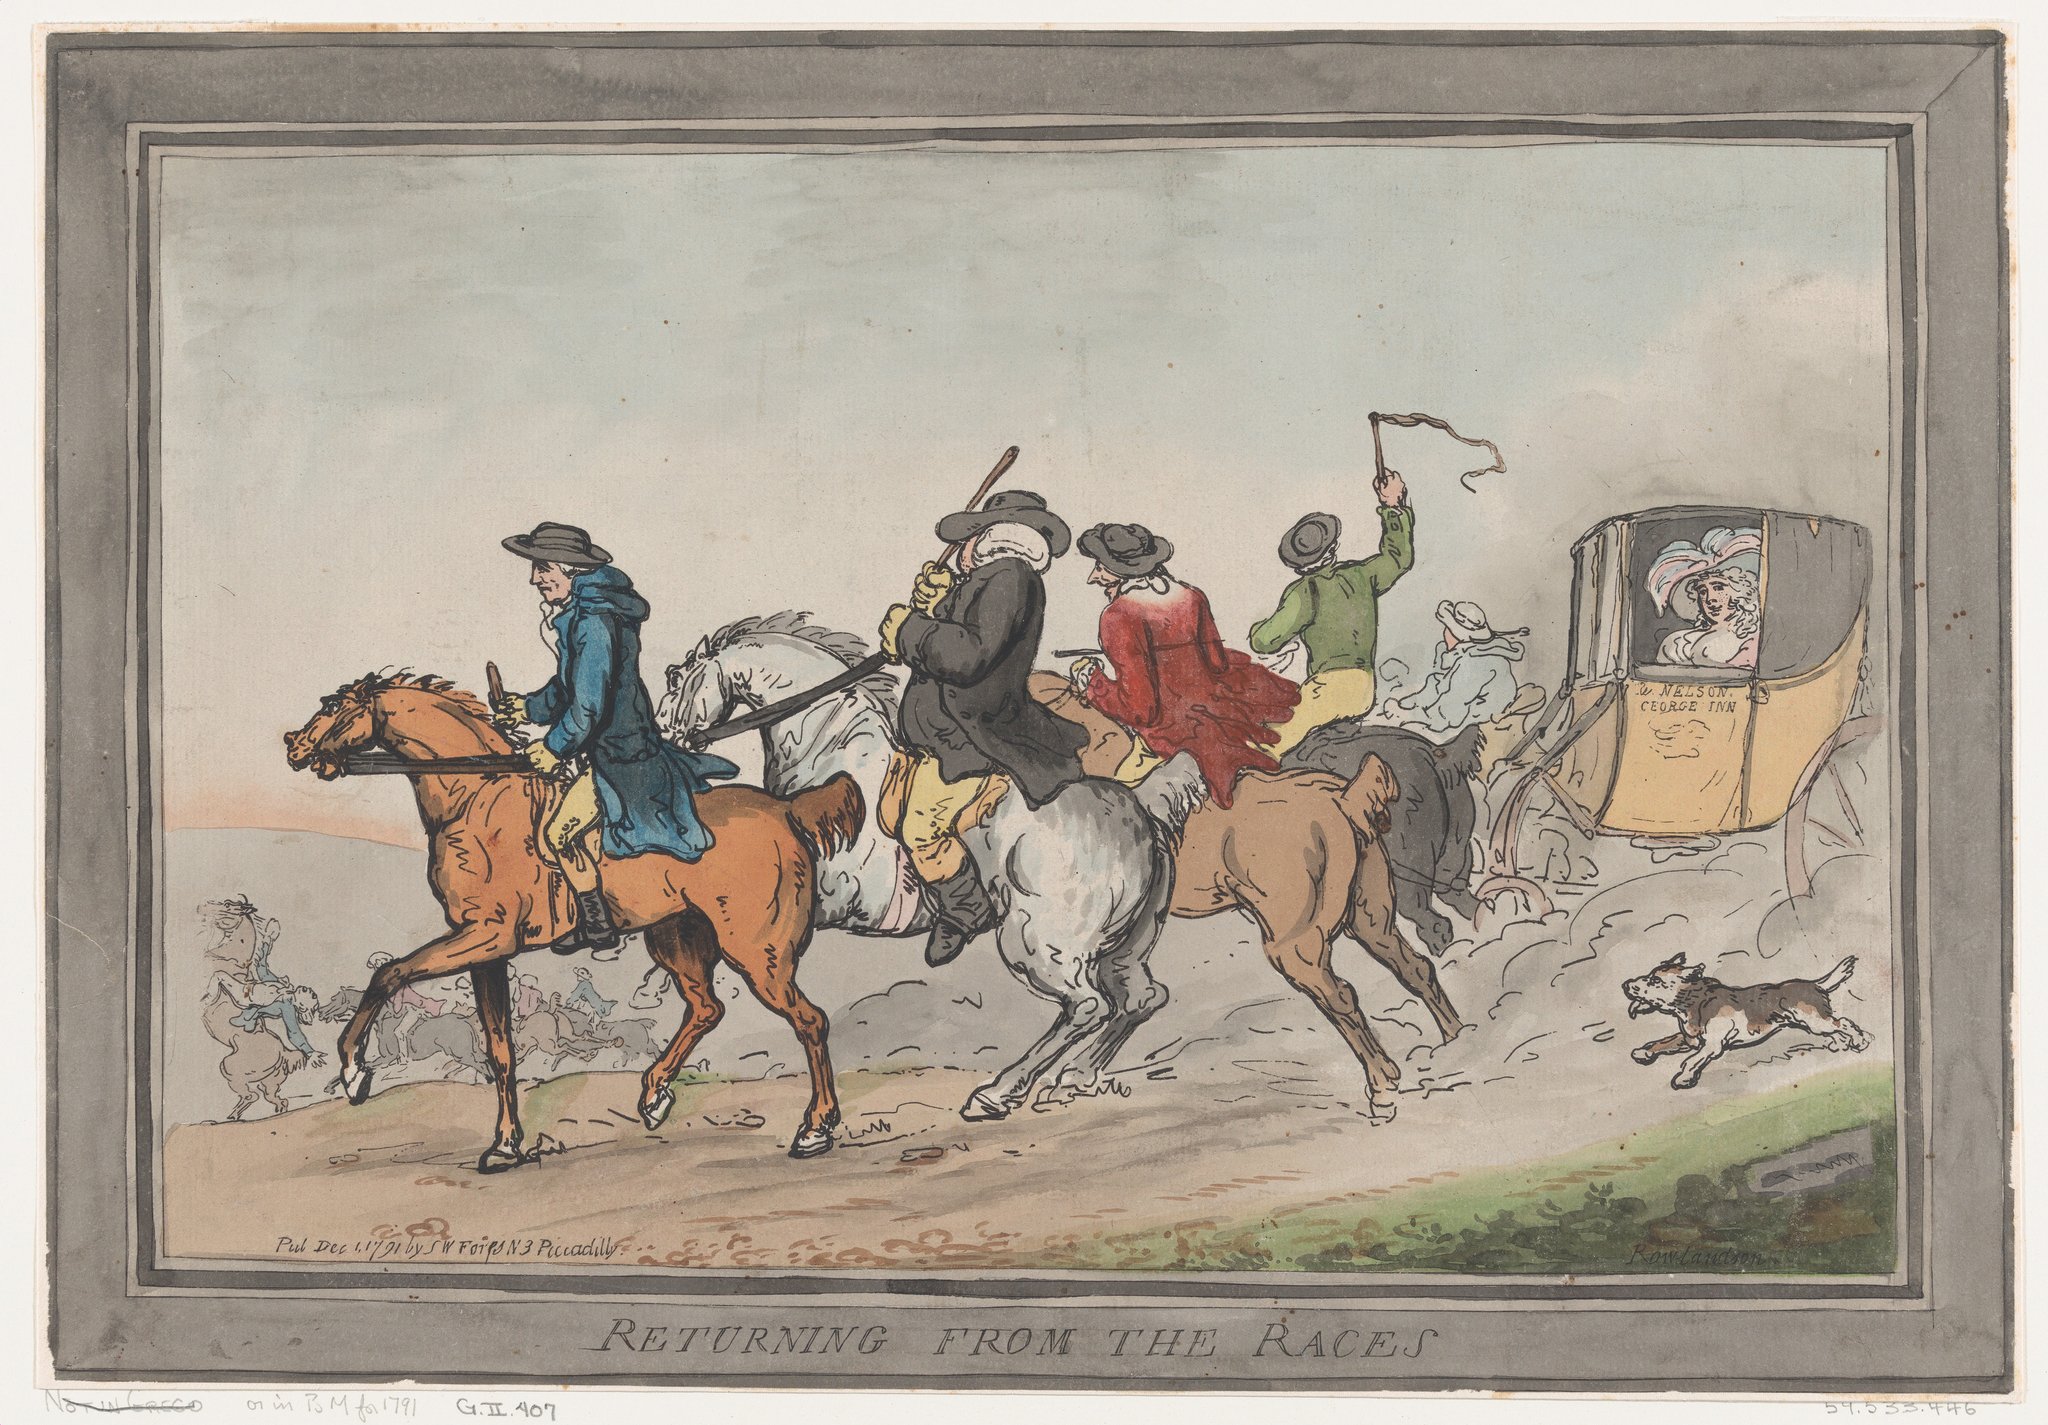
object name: print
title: Returning from the Races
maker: thomas rowlandson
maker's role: artist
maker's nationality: british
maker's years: 1757-1827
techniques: etching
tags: men,women,dogs,horses,carriages